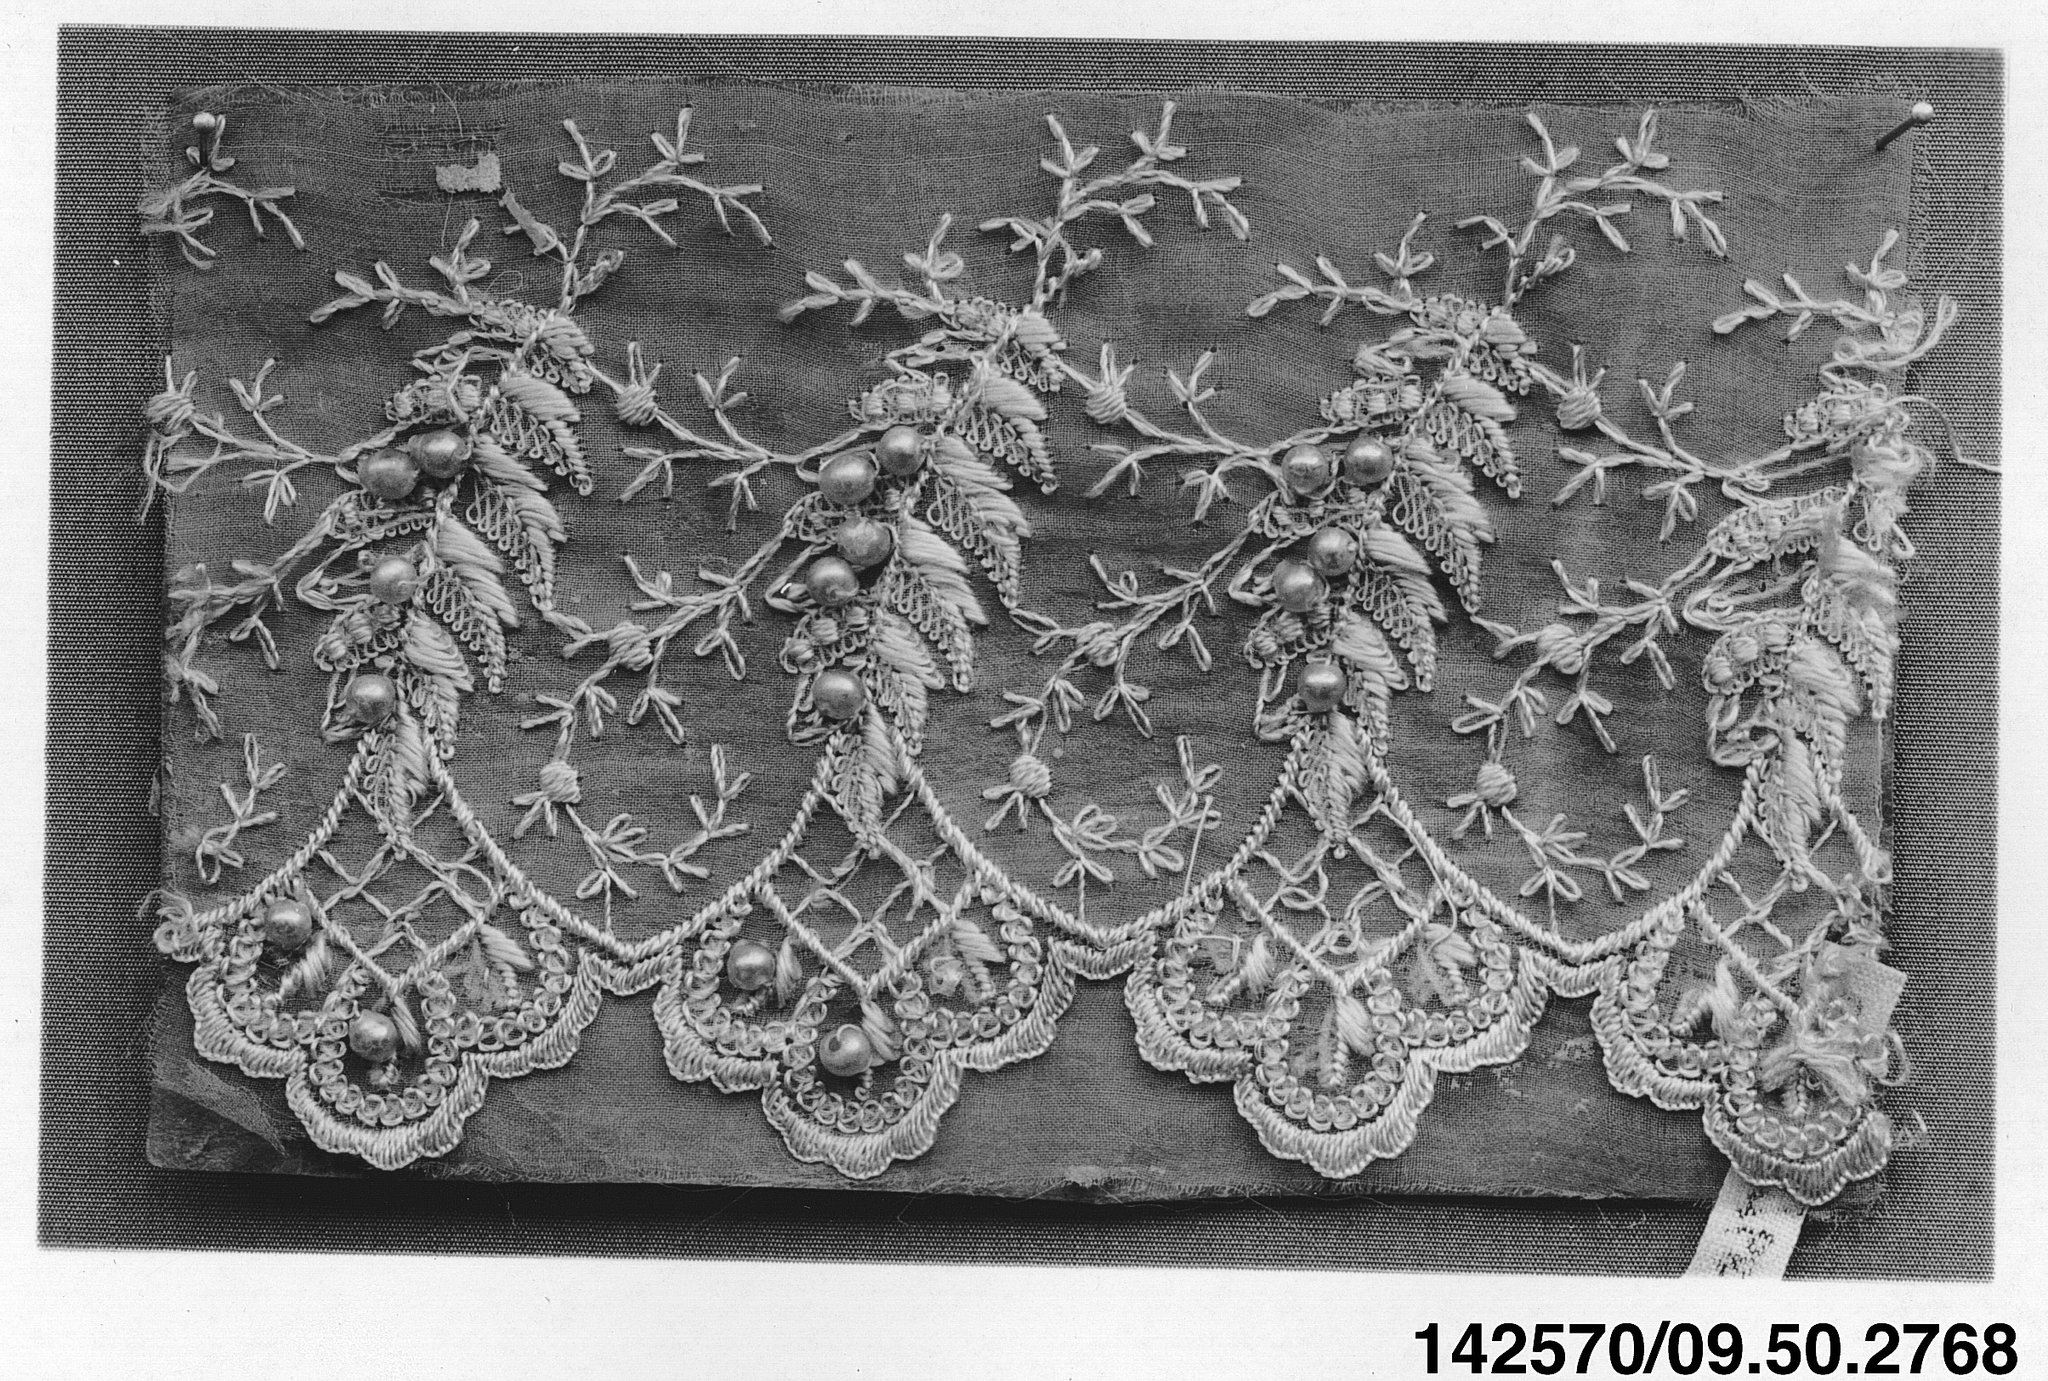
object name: border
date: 1801-1900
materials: silk, wool